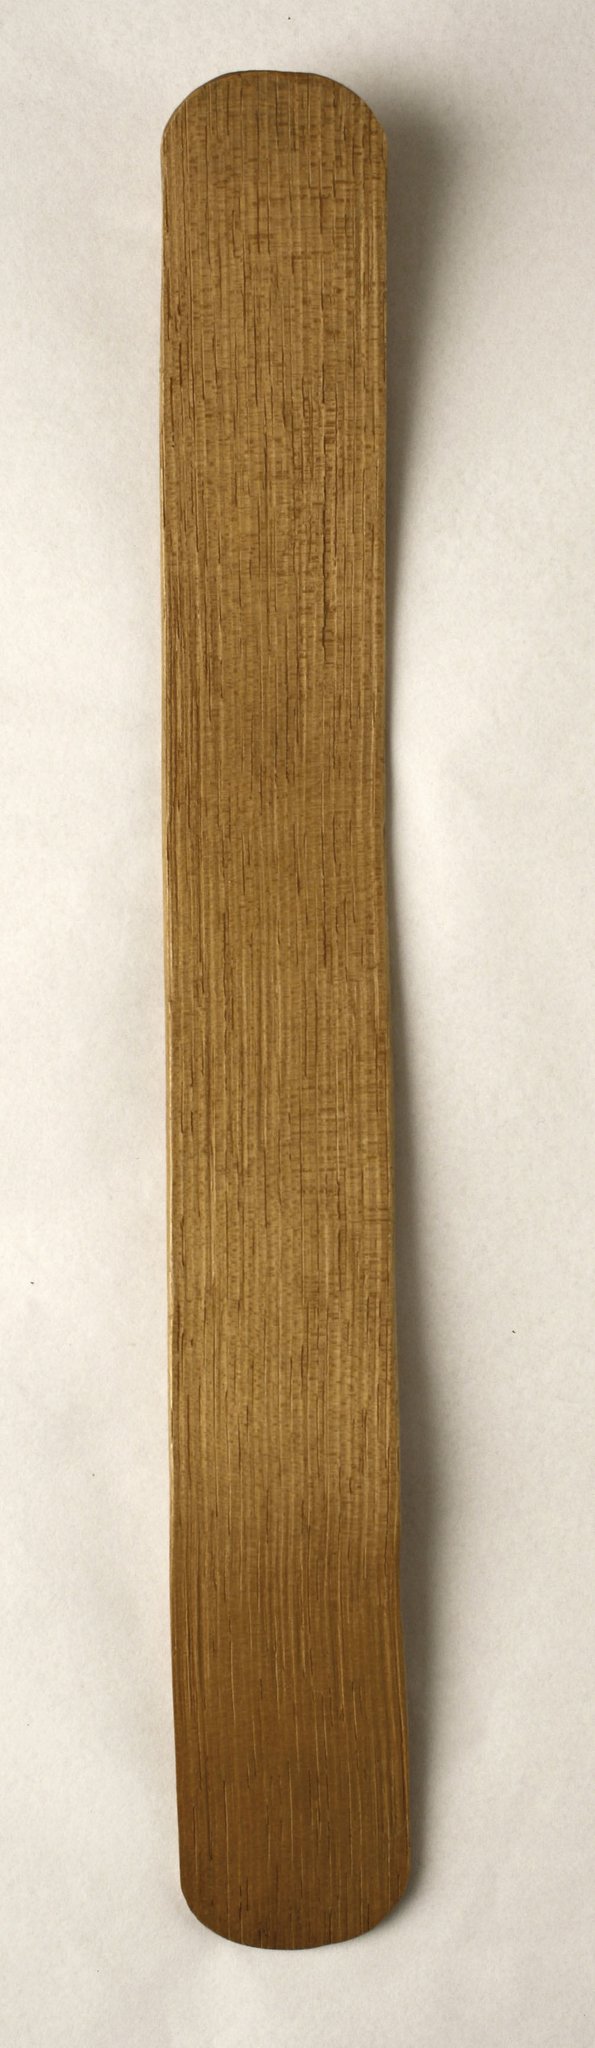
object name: busk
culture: american or european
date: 1701-1800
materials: wood